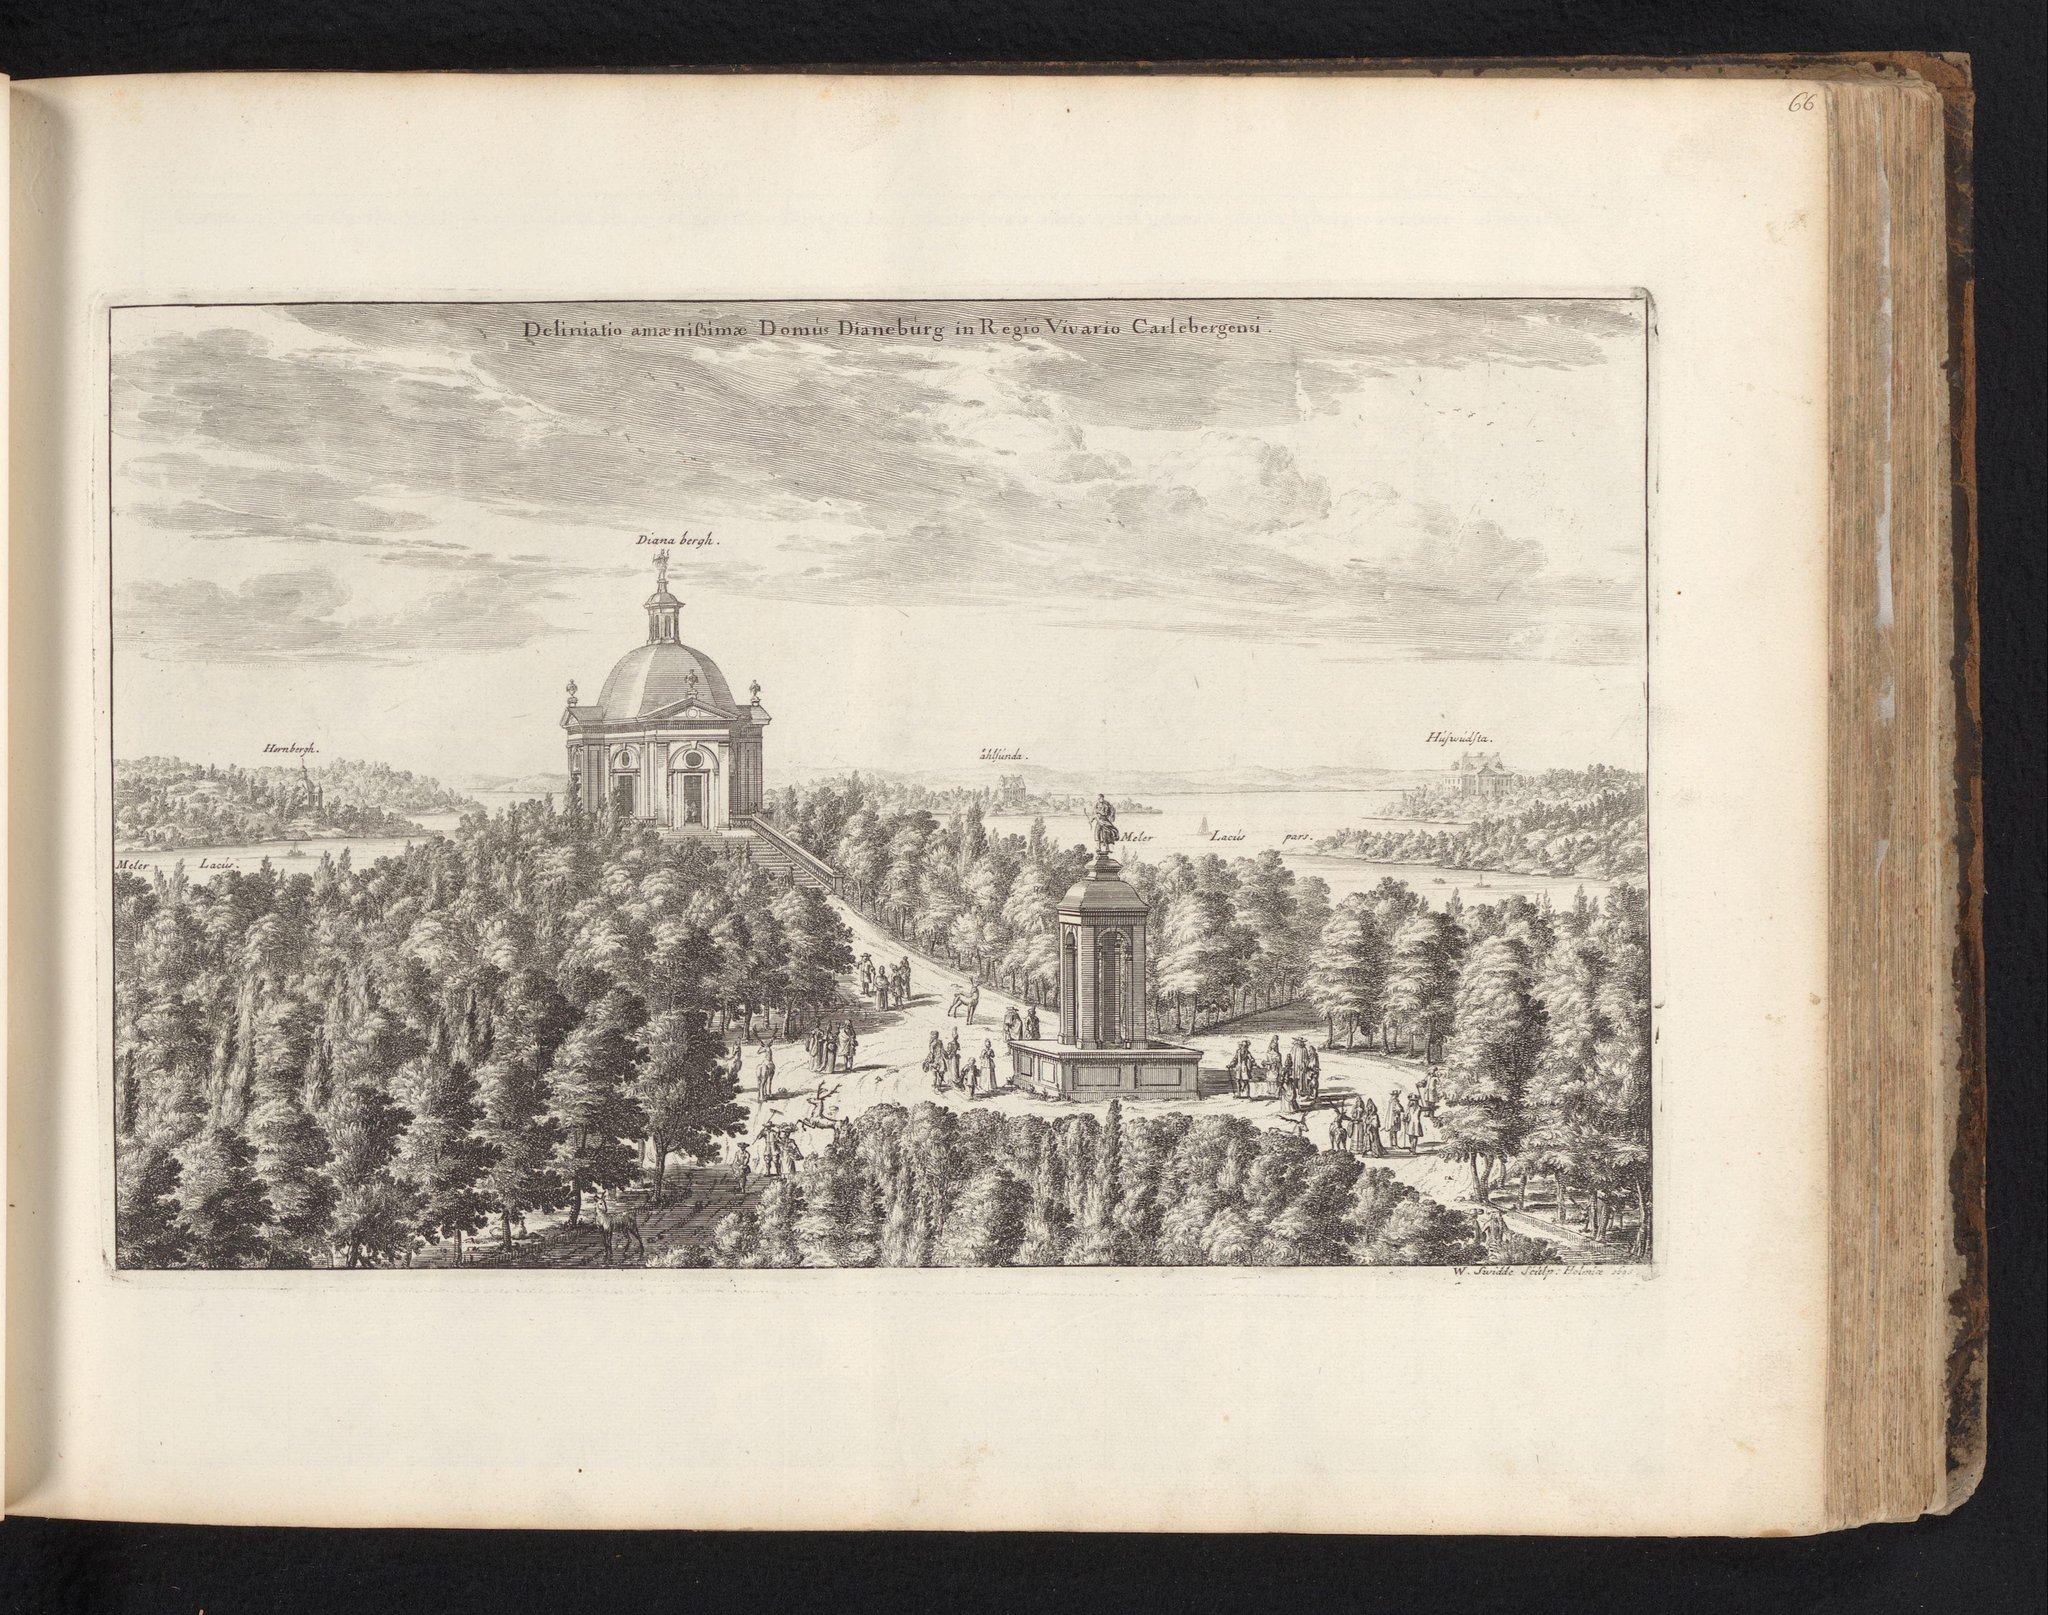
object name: album leaf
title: Park van slot Karlberg met op een heuvel de jachttempel Dianeberg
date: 1693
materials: paper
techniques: etching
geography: stockholm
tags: garden, karlberg palace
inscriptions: date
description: Kungliga Biblioteket, 'Suecia': http://www.kb.se/samlingarna/Kartor-bilder/Suecia-antiqua/ (geraadpleegd november 2016).